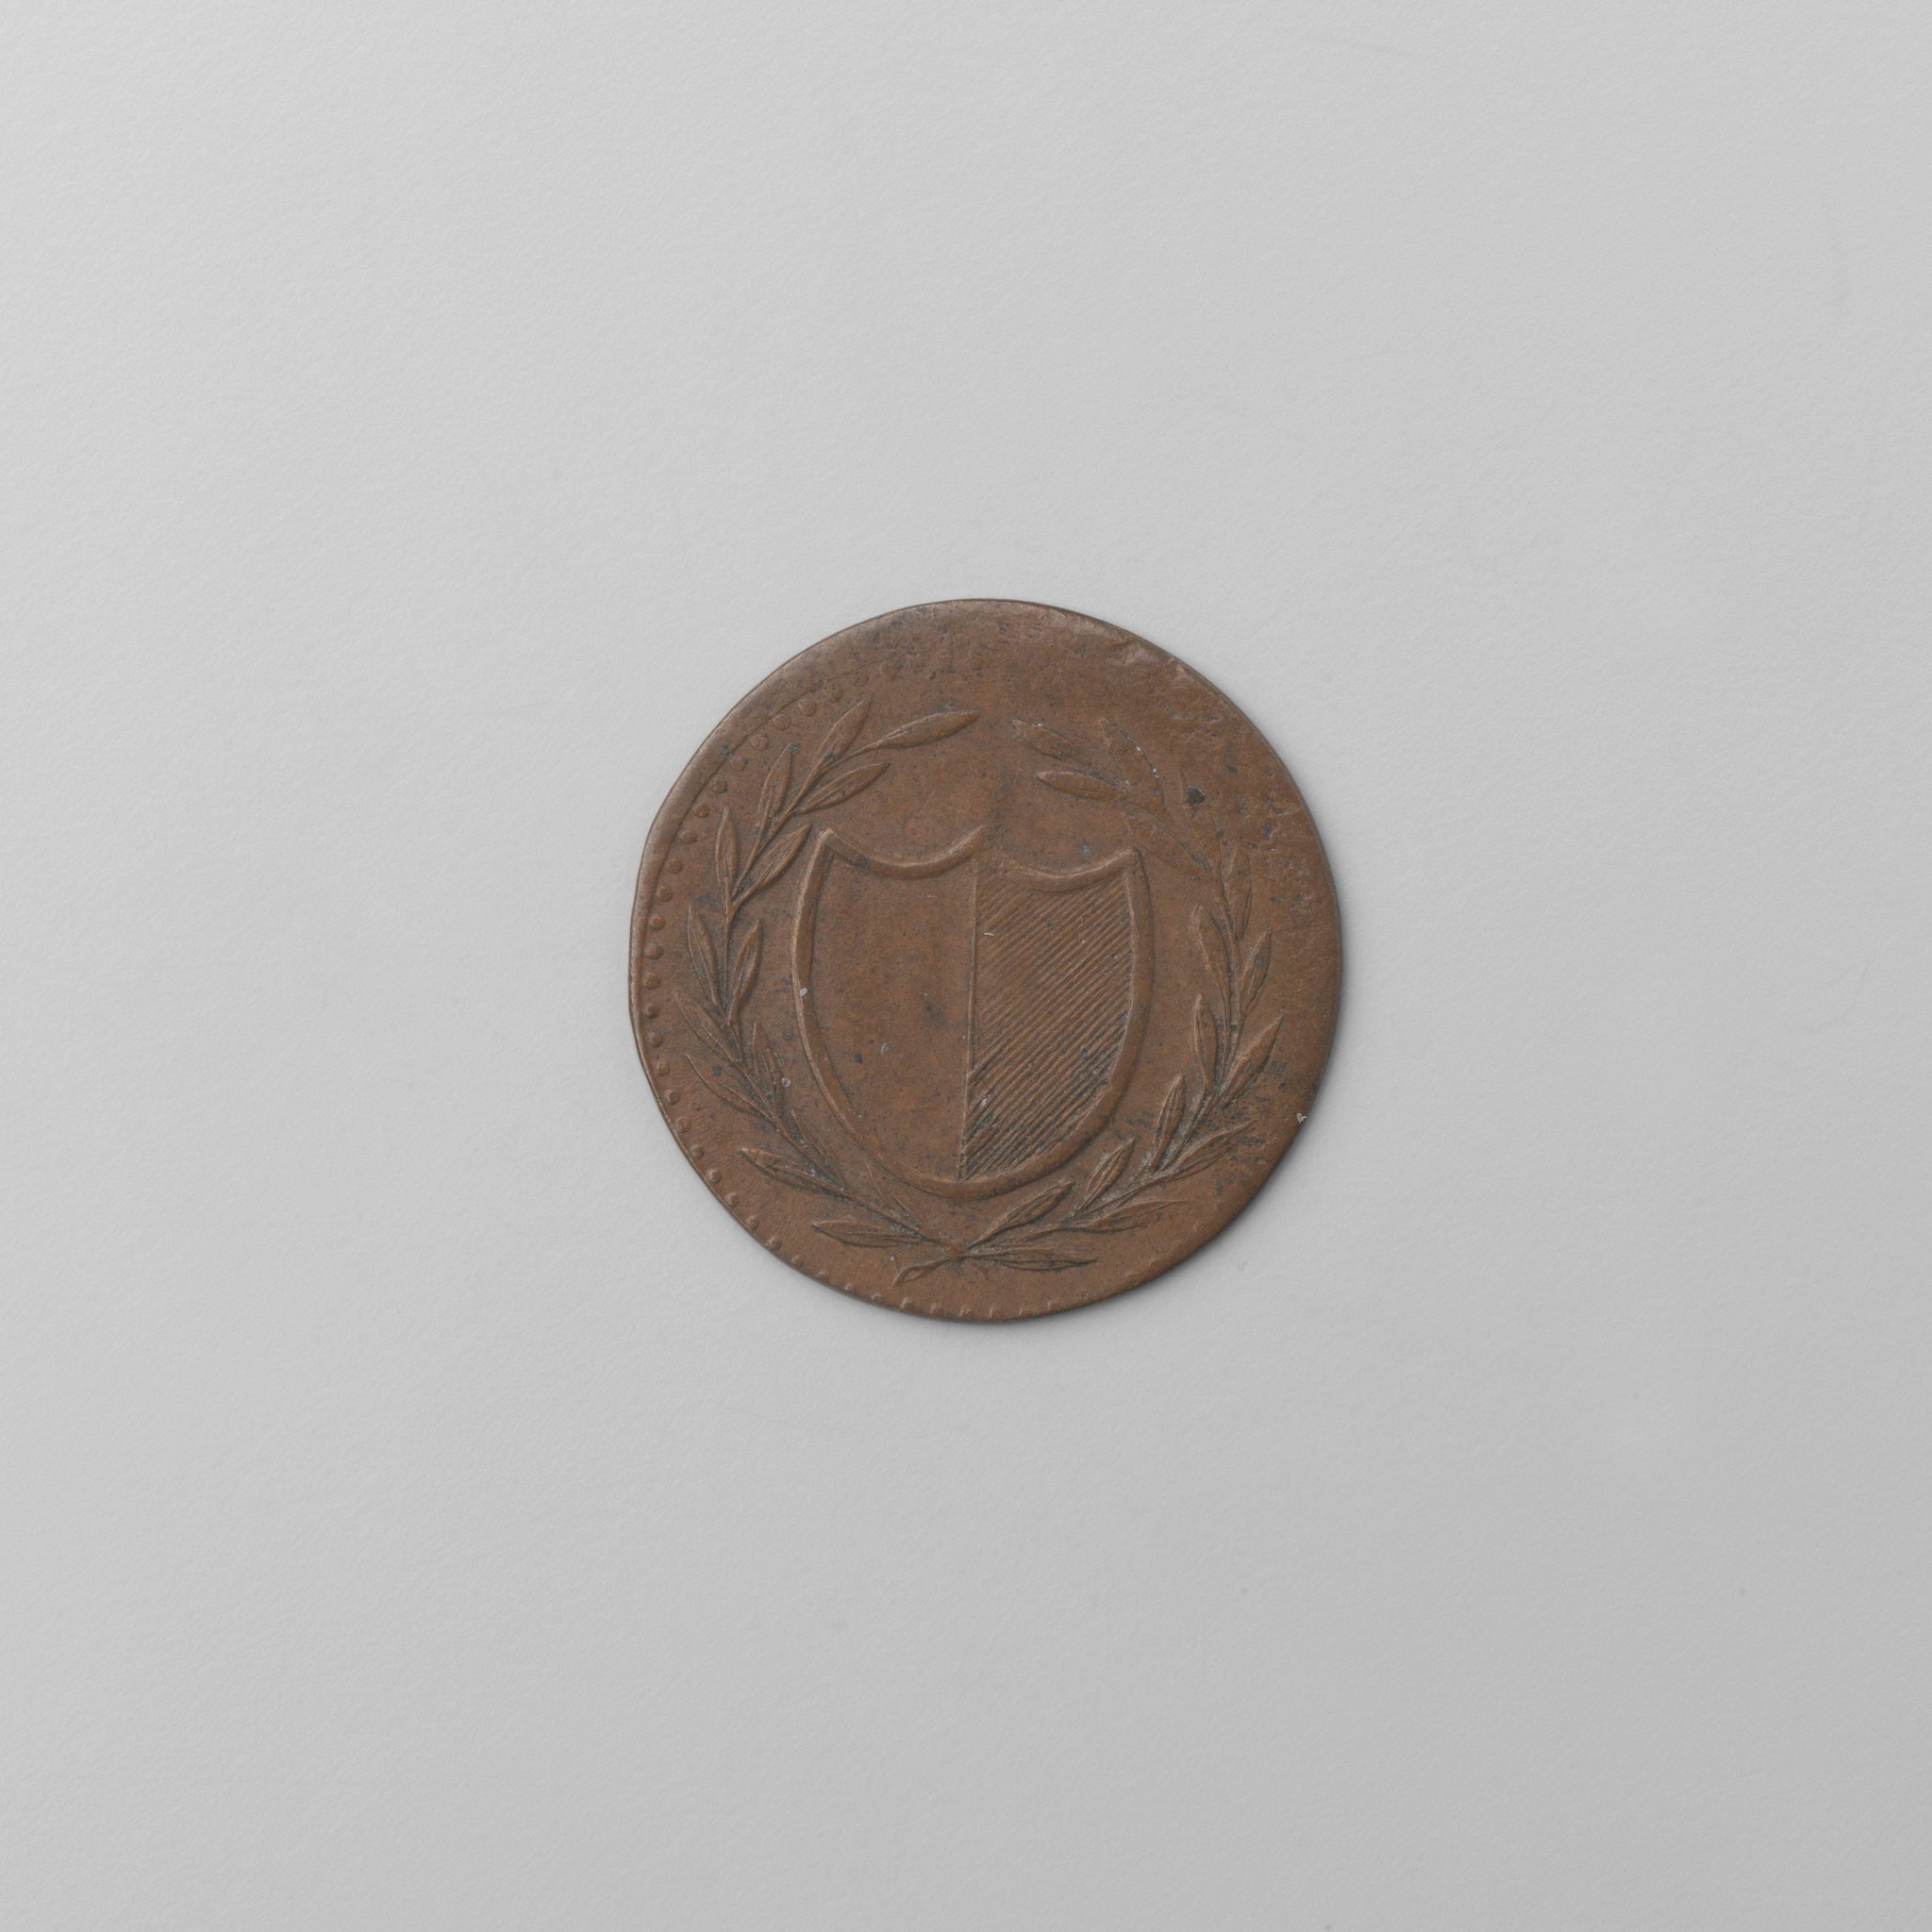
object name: coin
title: Nederland, Bleyensteinse duit, 1819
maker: william i of the netherlands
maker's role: koning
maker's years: 1772-1843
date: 1819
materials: copper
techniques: striking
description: Koperen munt. Voorzijde: tussen lauwertakken ovaal wapenschild. Keerzijde: tussen aluwertakken waarde-aanduiding I , waaronder jaartal. Gladde rand.